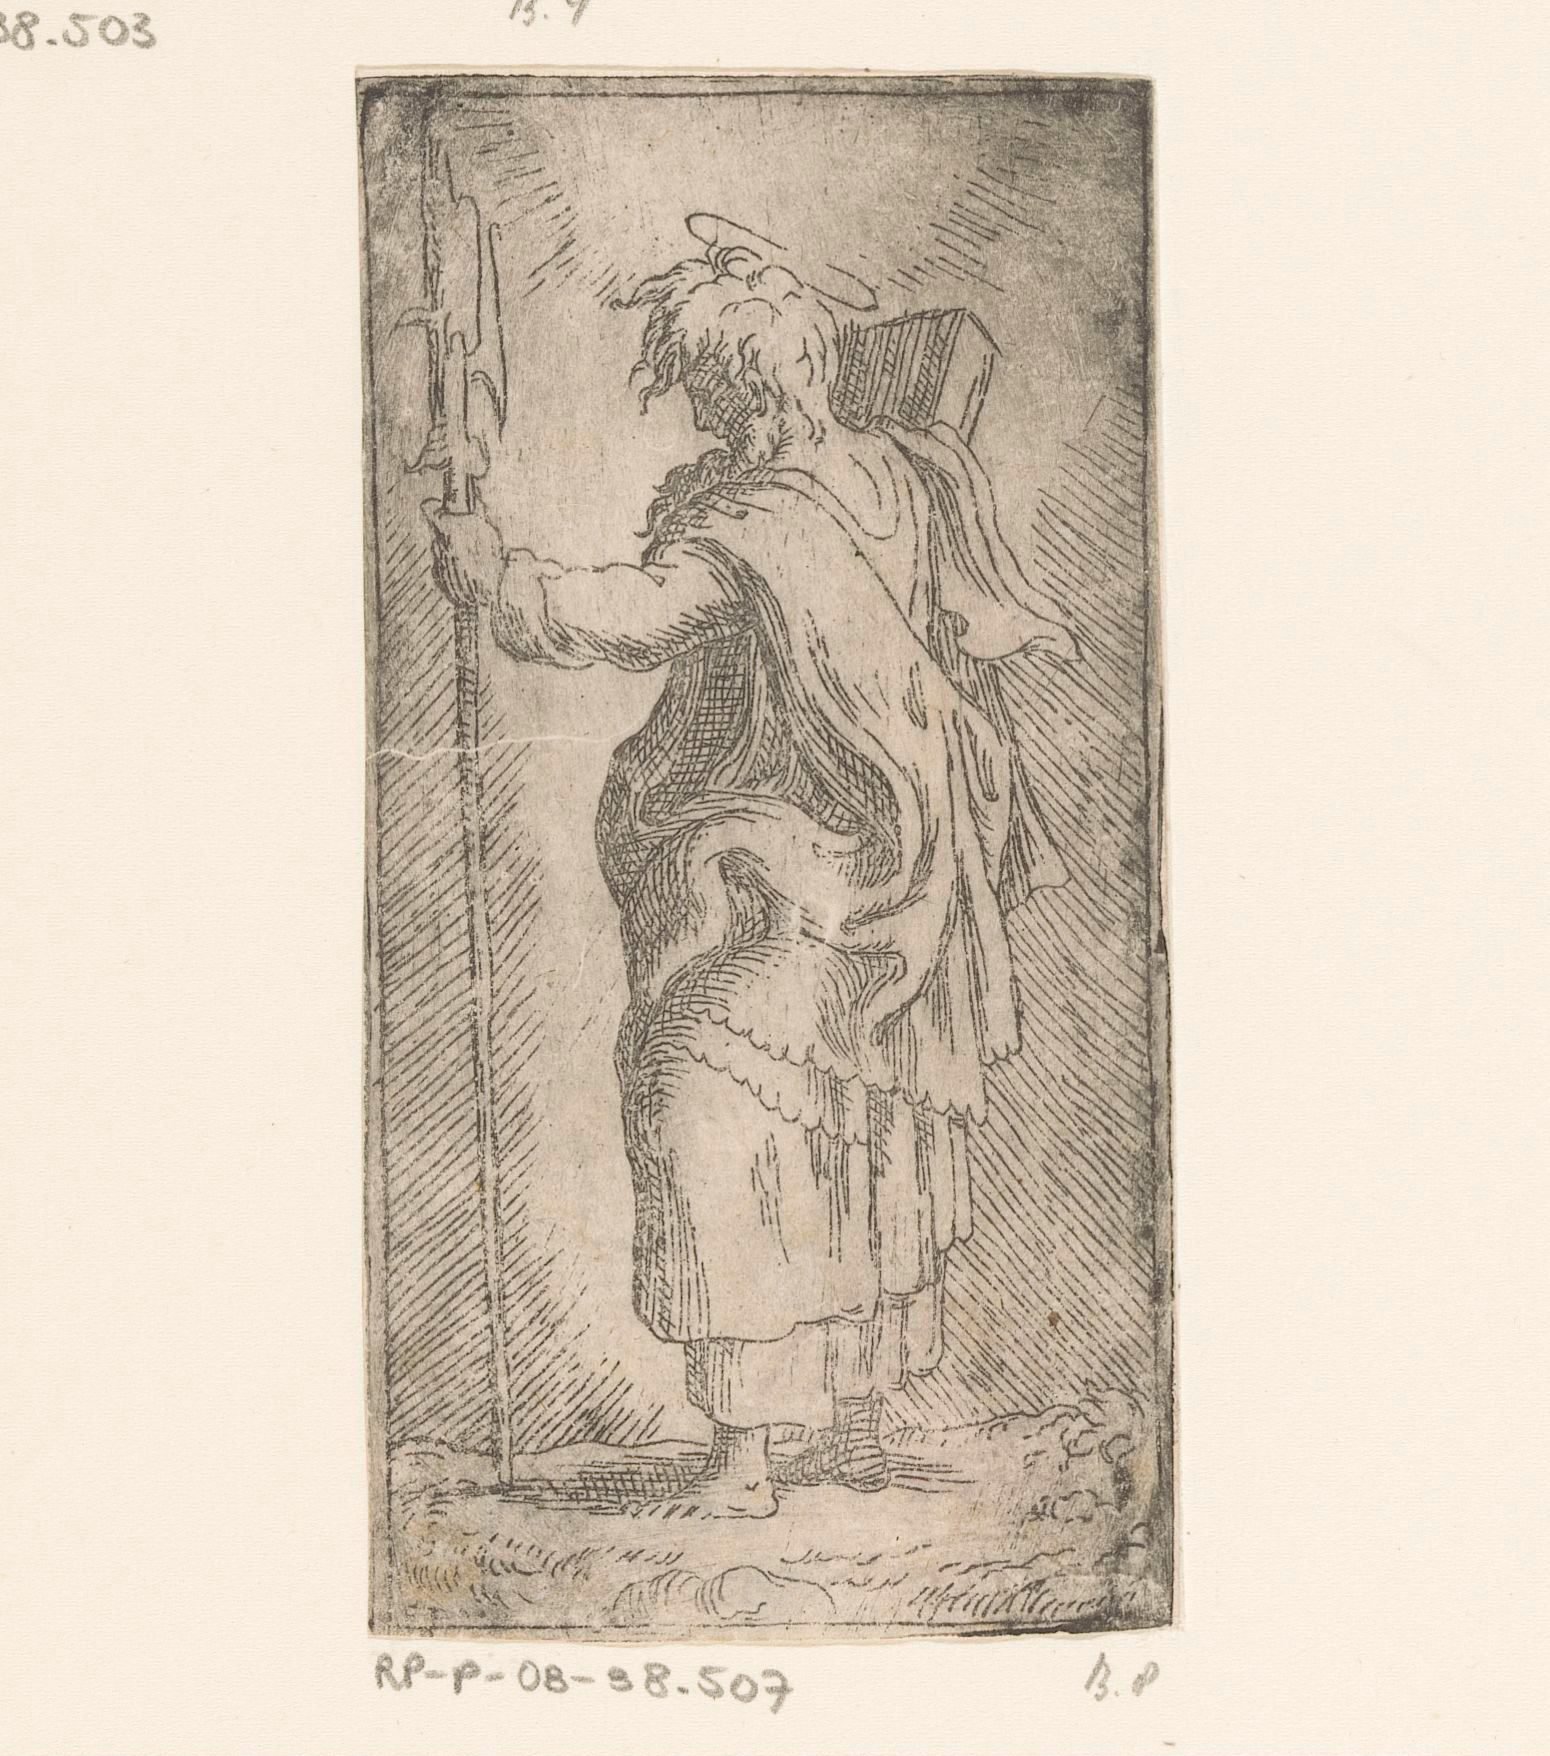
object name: print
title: De heilige Matteüs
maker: monogrammist fp (italië; 16e eeuw)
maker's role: print maker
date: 1500-1599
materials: paper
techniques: etching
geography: italy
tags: the apostle and evangelist matthew (mattheus); possible attributes: angel, axe, book, halberd, pen and inkhorn, purse, scroll, square, sword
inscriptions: collector's mark: Lugt 240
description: Deze prent maakt deel uit van een reeks van dertien prenten van Christus en de twaalf apostelen.